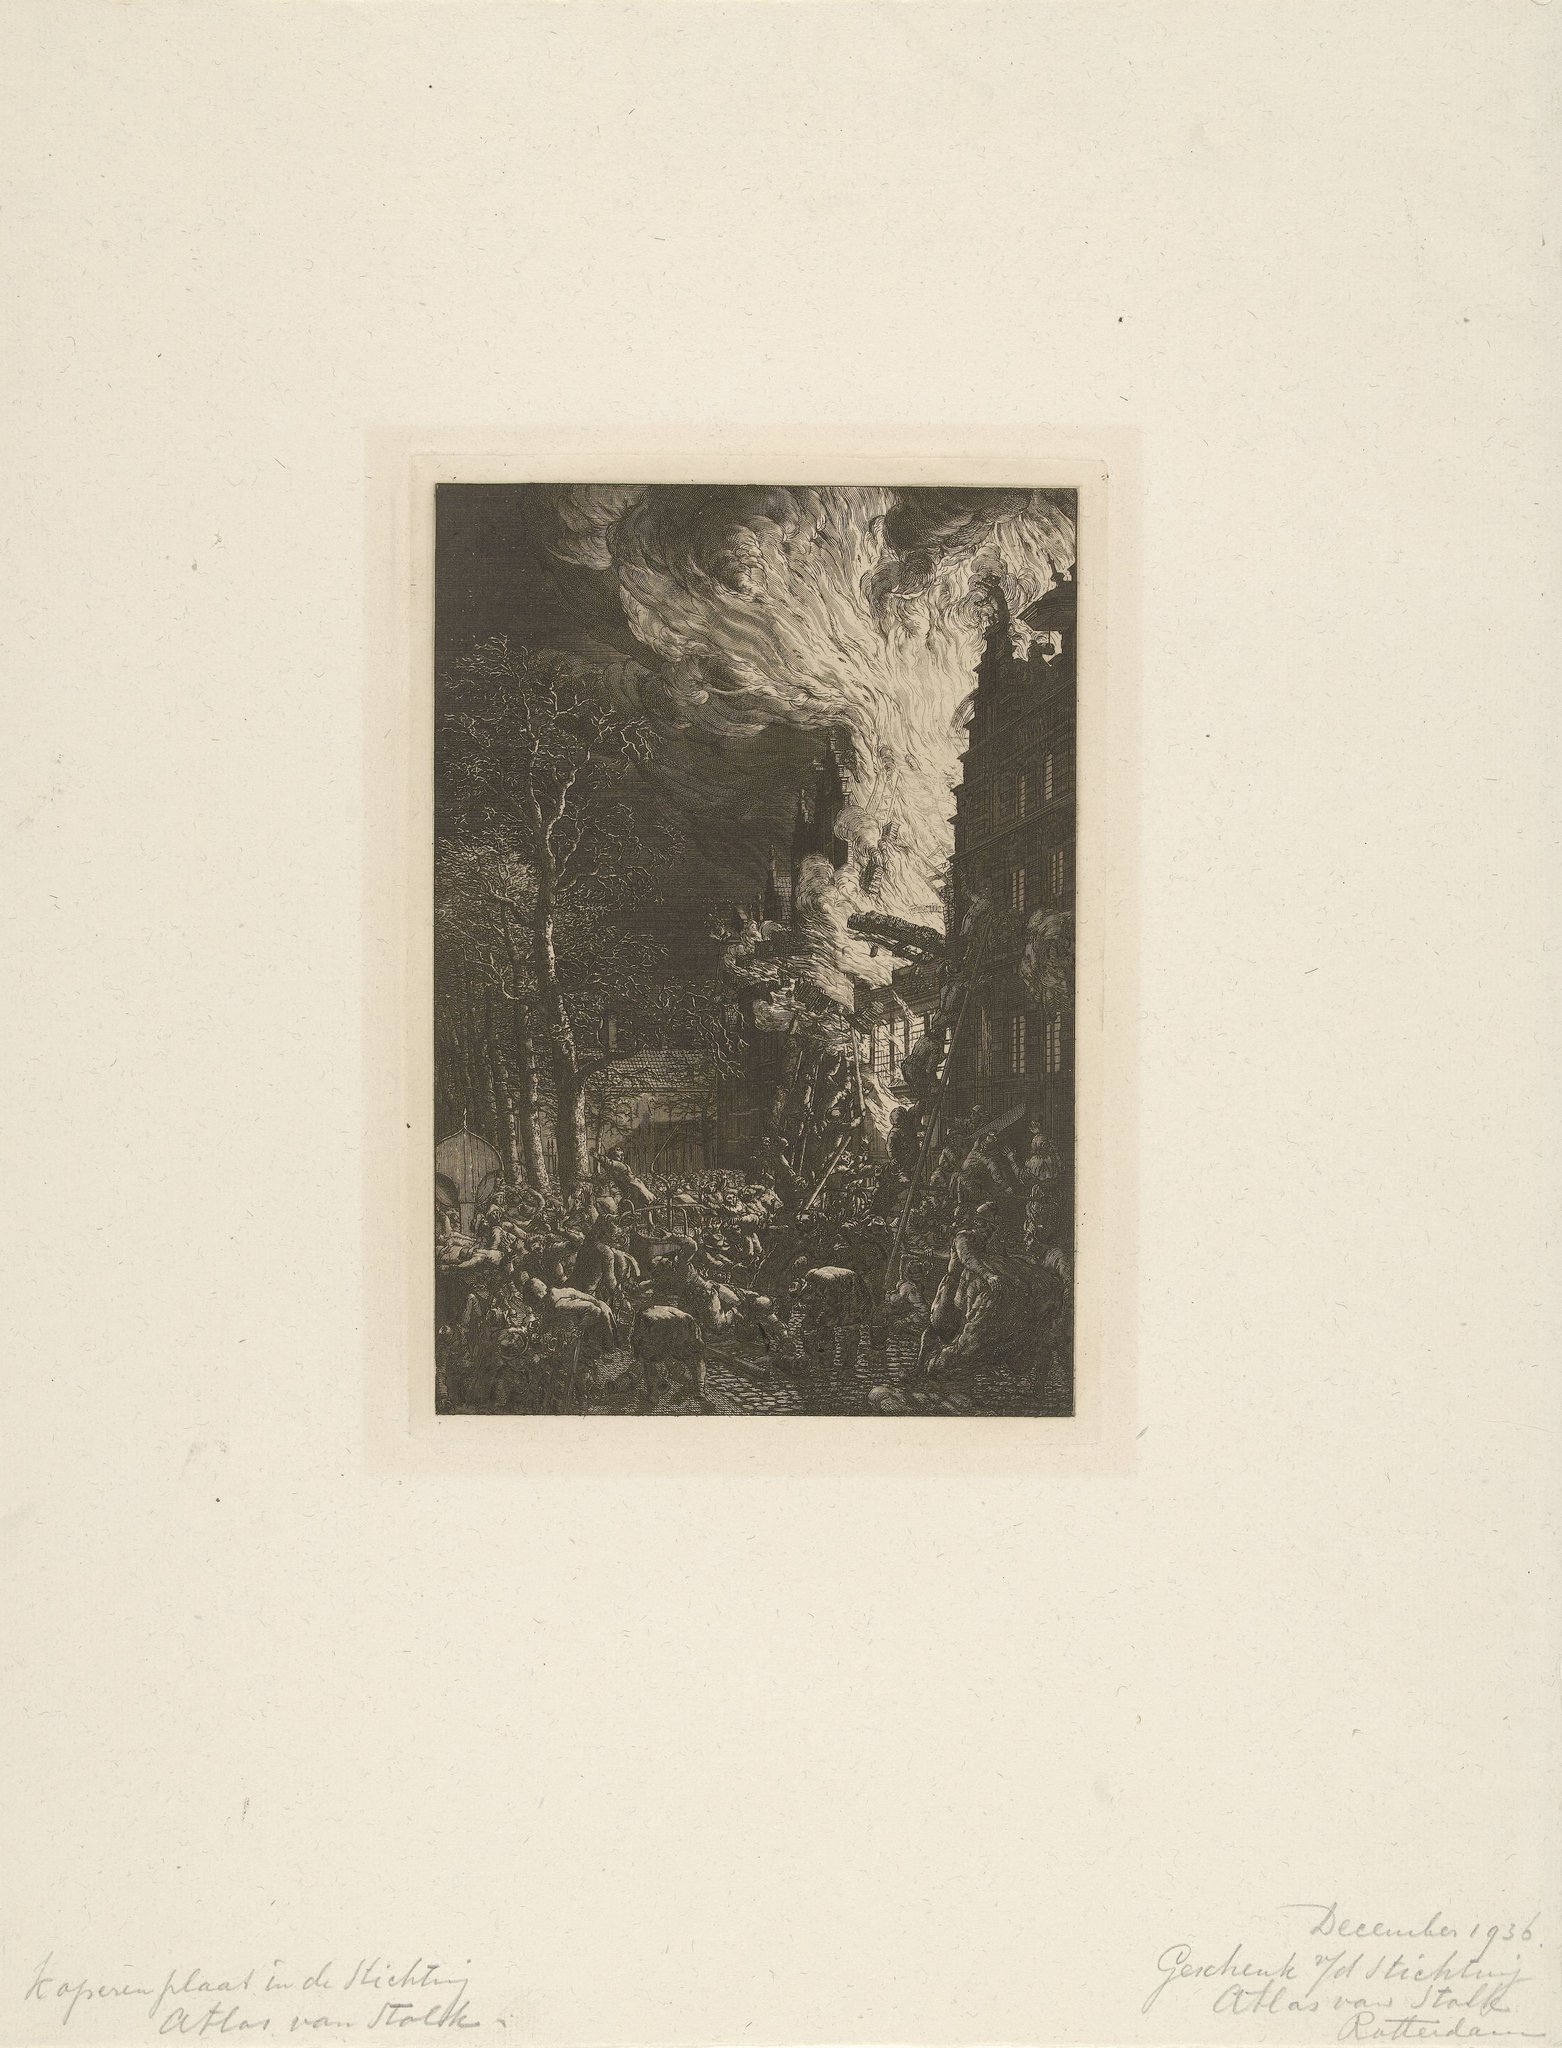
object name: print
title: Brand op de Oude Schans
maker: jan van der heyden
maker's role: draughtsman, painter, print maker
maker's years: 1637-1712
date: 1733-1735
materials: paper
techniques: etching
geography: amsterdam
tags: on fire, ablaze, fire-fighting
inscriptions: collector's mark: Lugt 2228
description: Oorspronkelijk als illustratie gebruikt in: Jan van der Heyden, Beschryving der nieuwlyks uitgevonden en geoctrojeerde slang-brand-spuiten, en haare wyze van brand-blussen, tegenwoordig binnen Amsterdam in gebruik zijnde. Amsterdam: 1735. Dit exemplaar betreft een moderne druk van de verkleinde versie van de prent met dezelfde voorstelling uit de eerste druk van het boek van Van der Heyden uit 1690. Deze verkleinde versie gebruikt in de tweede editie van het boek van Van der Heyden in 1735. Boek uit 1735 zoek in bibliotheek Rijksmuseum